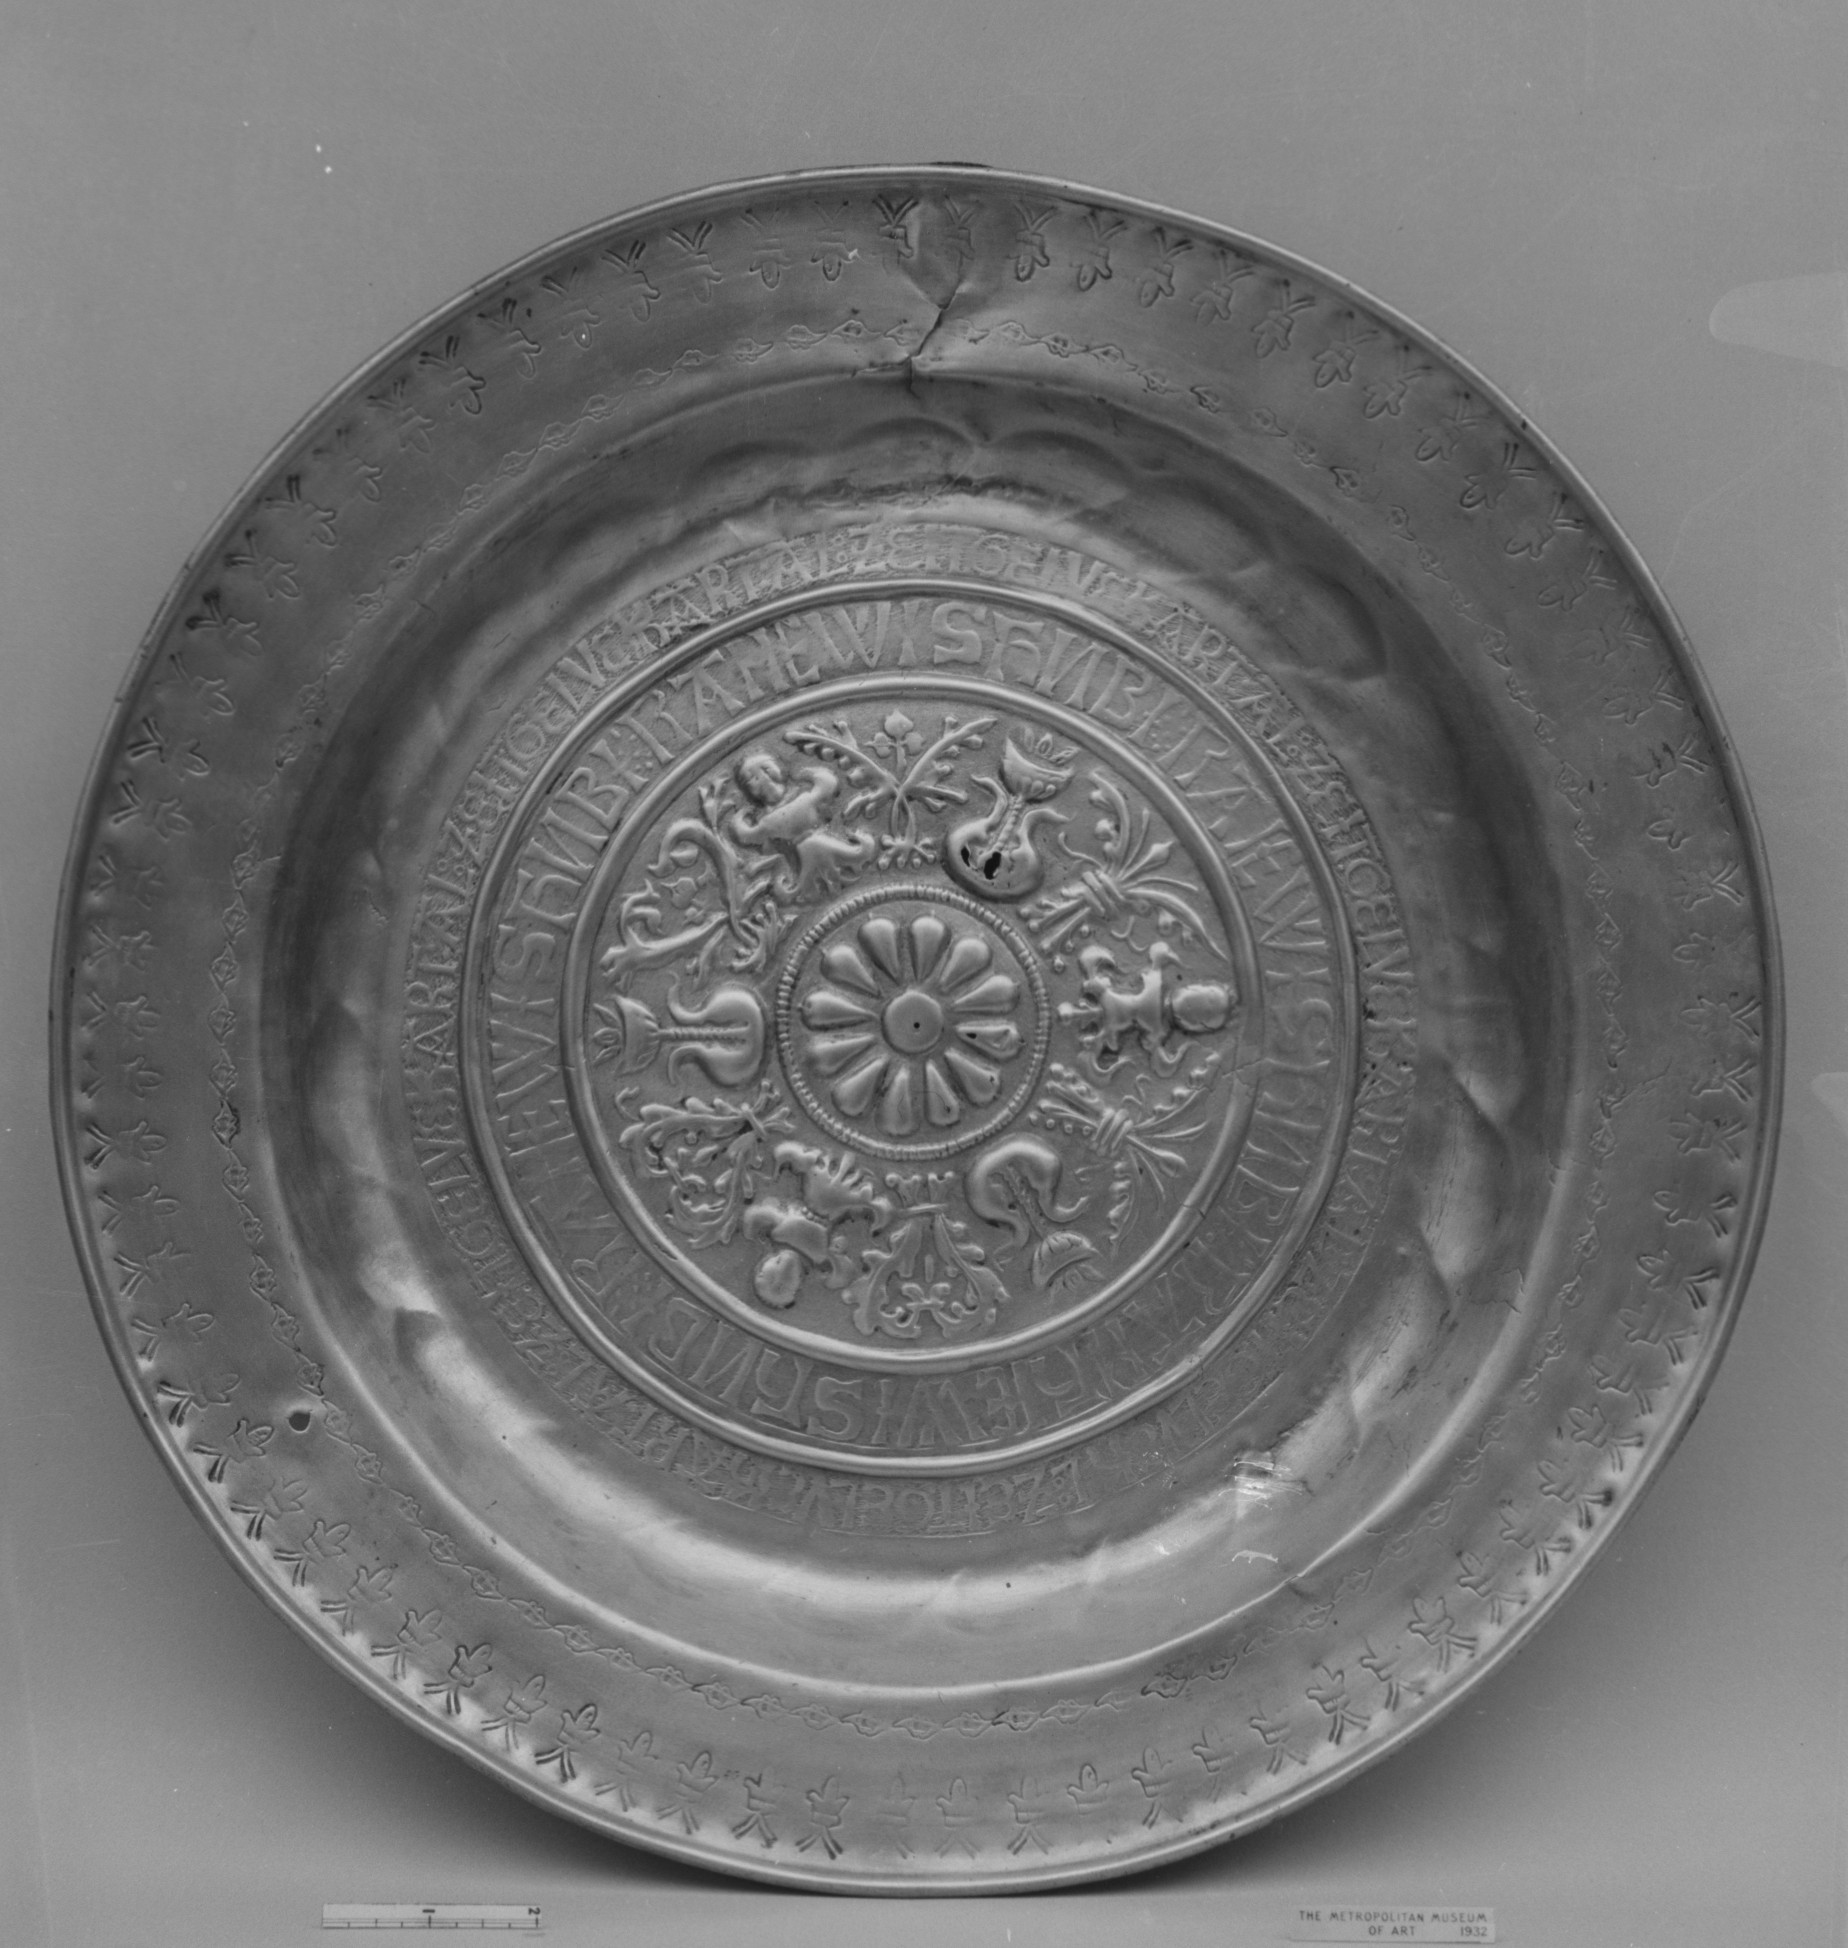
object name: dish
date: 1501-1533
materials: brass